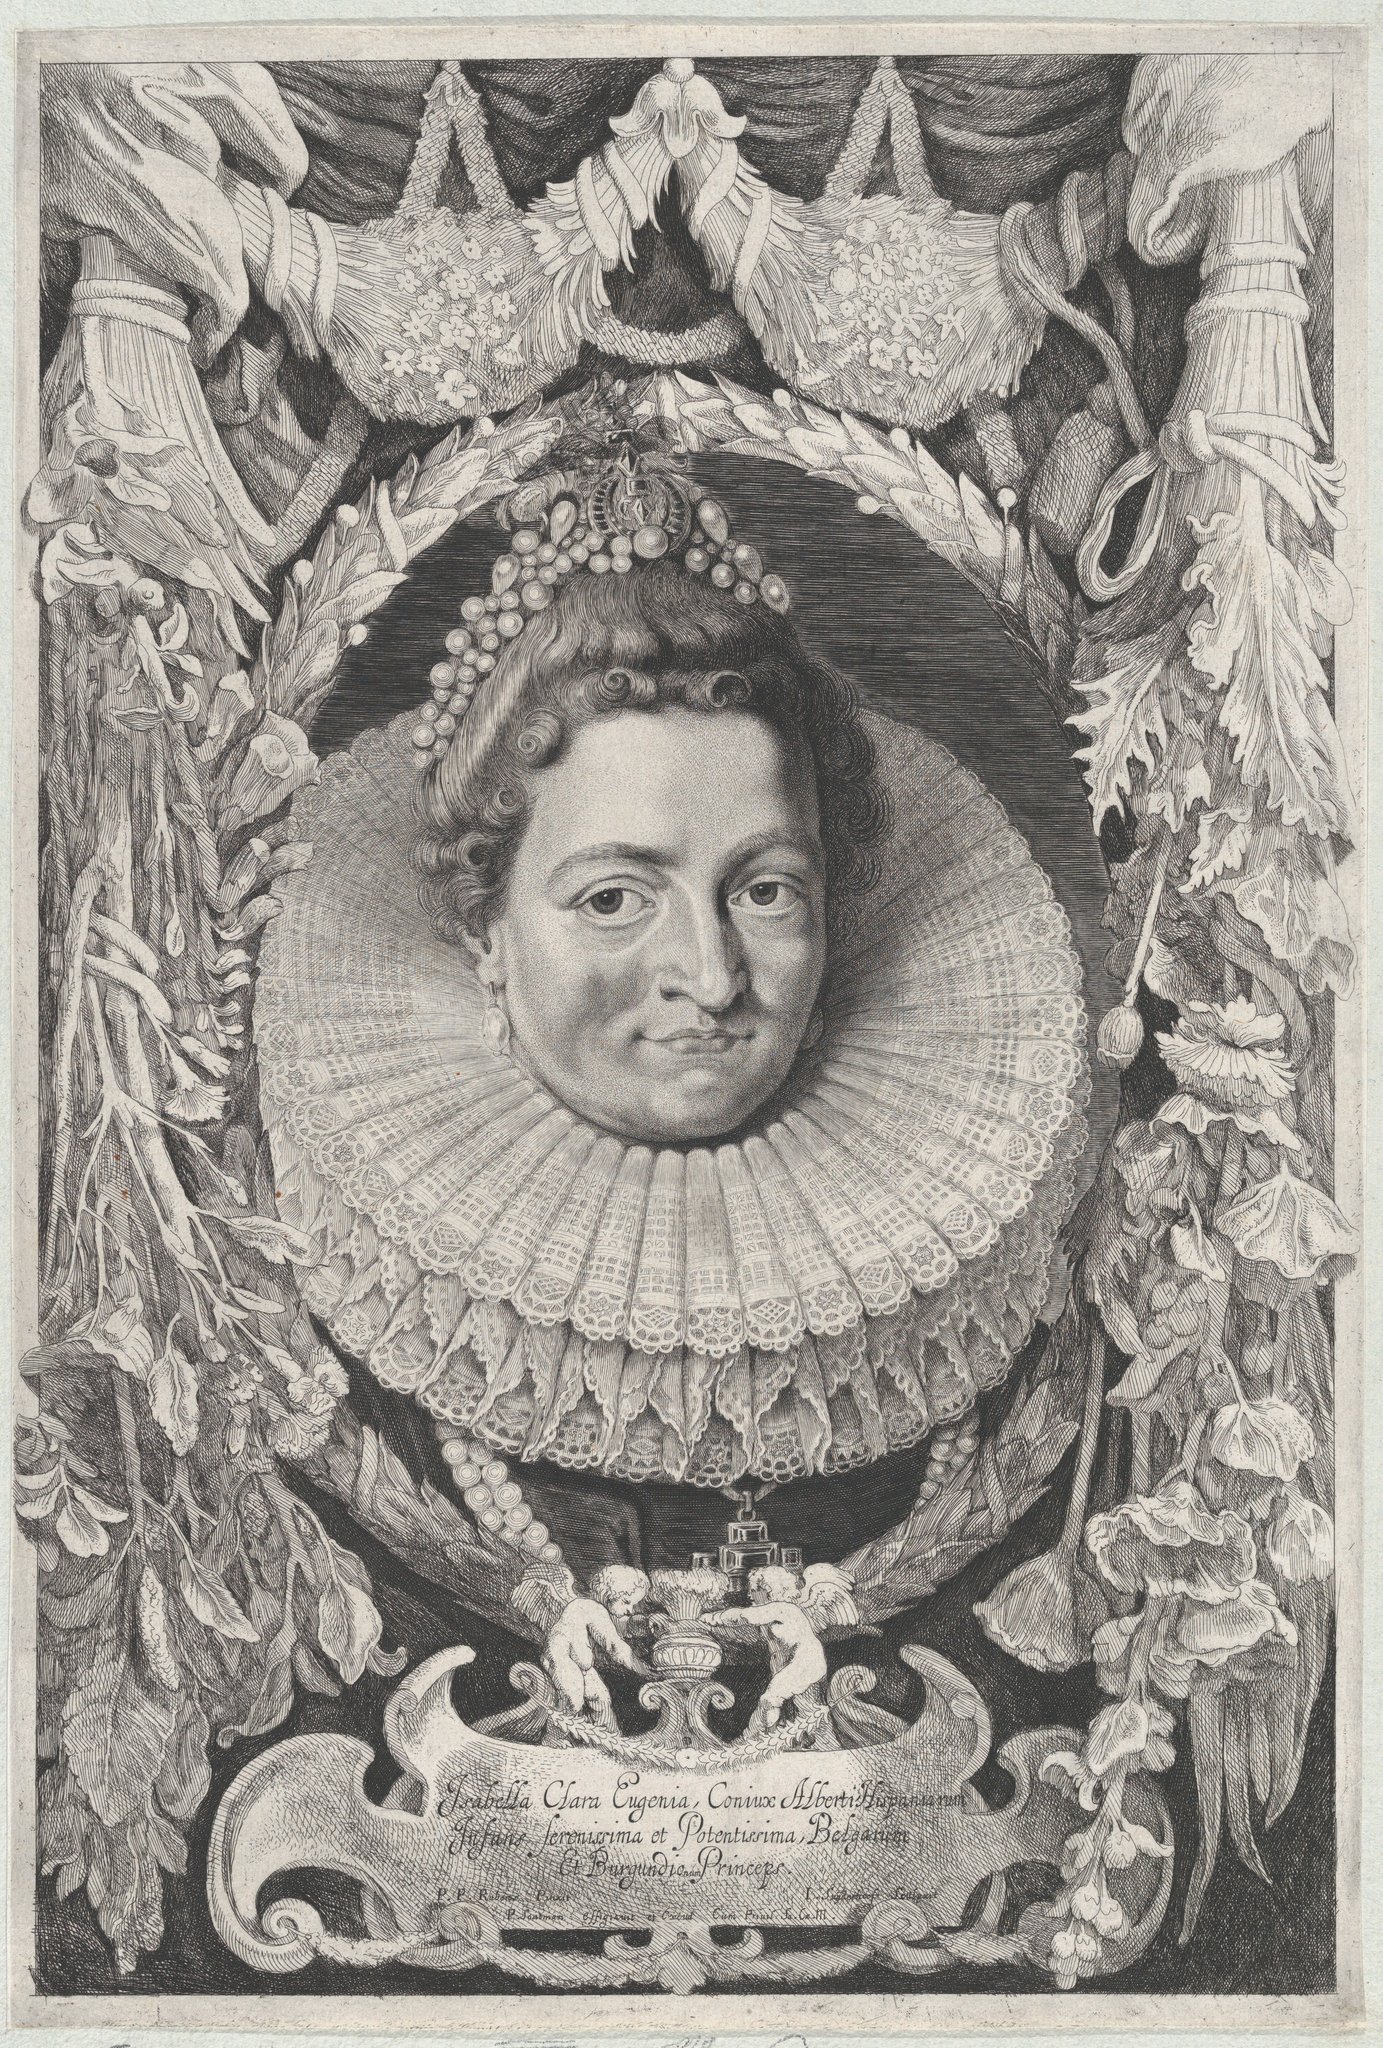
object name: print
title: Portrait of Albert VII, Archduke of Austria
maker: jonas suyderhoef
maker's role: artist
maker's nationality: dutch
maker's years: 1613-1686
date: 1650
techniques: engraving, etching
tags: portraits,women